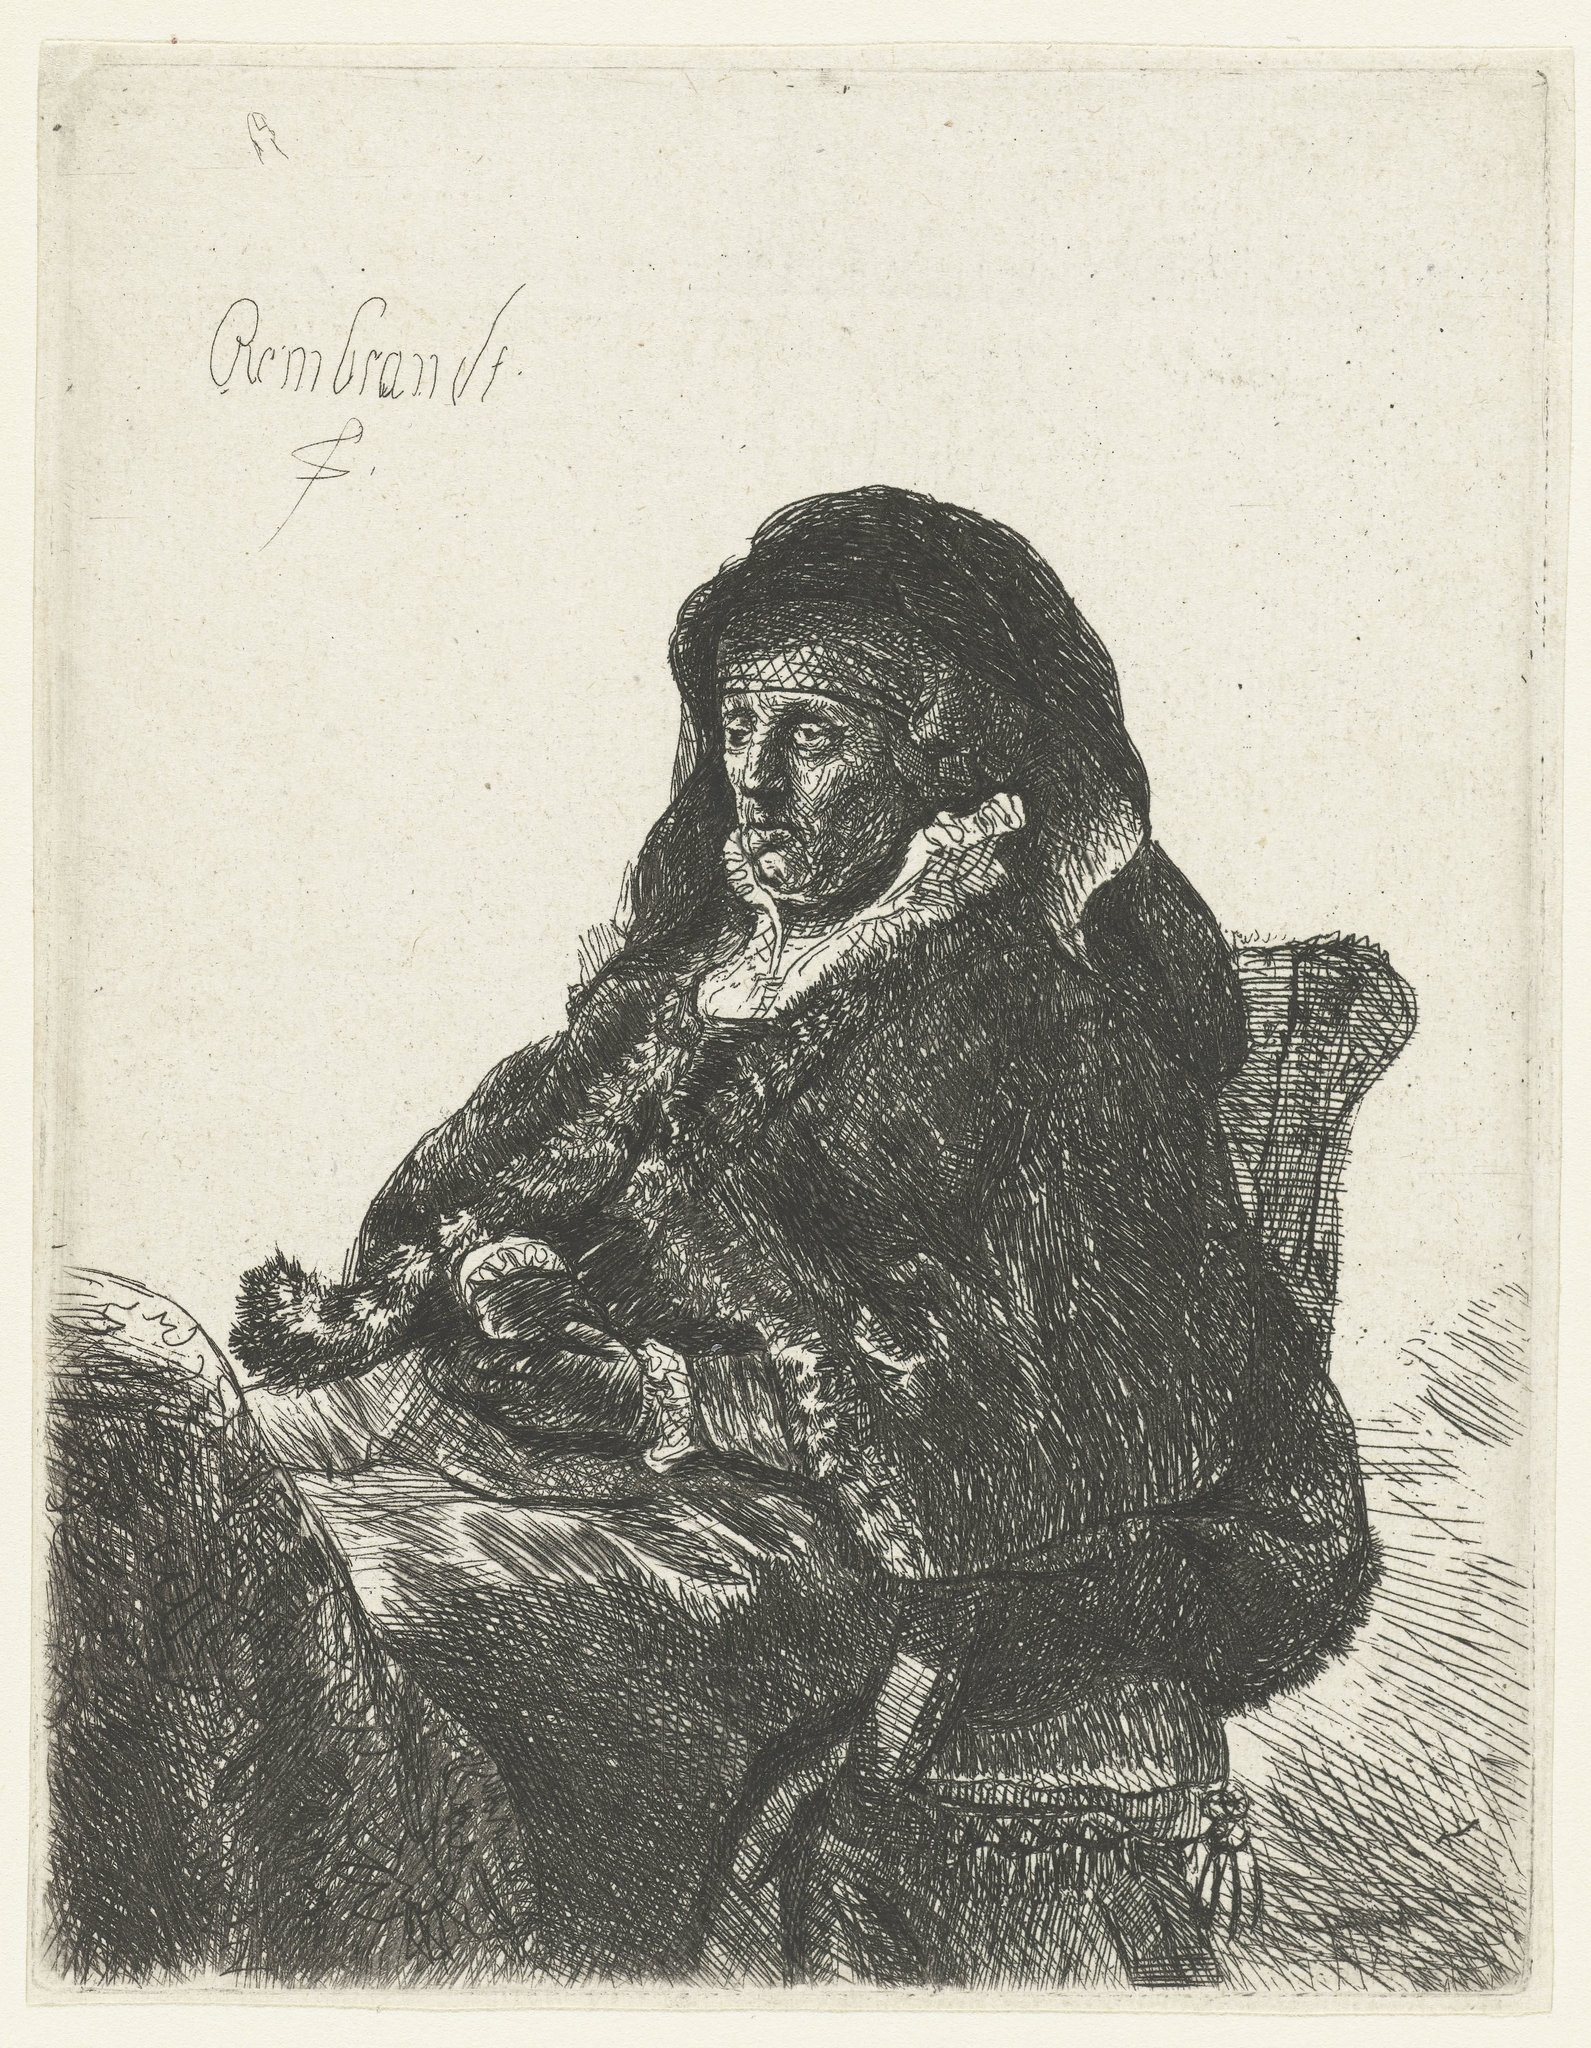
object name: print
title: Rembrandt's moeder als weduwe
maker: Anonymous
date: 1630-1700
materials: paper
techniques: etching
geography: netherlands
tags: widow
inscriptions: collector's mark: Lugt 240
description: Oude vrouw zittend op een stoel, gekleed als weduwe met zwarte handschoenen. Ook wel bekend als de moeder van Rembrandt, Neeltje Willemsdr. van Zuydtbrouck.